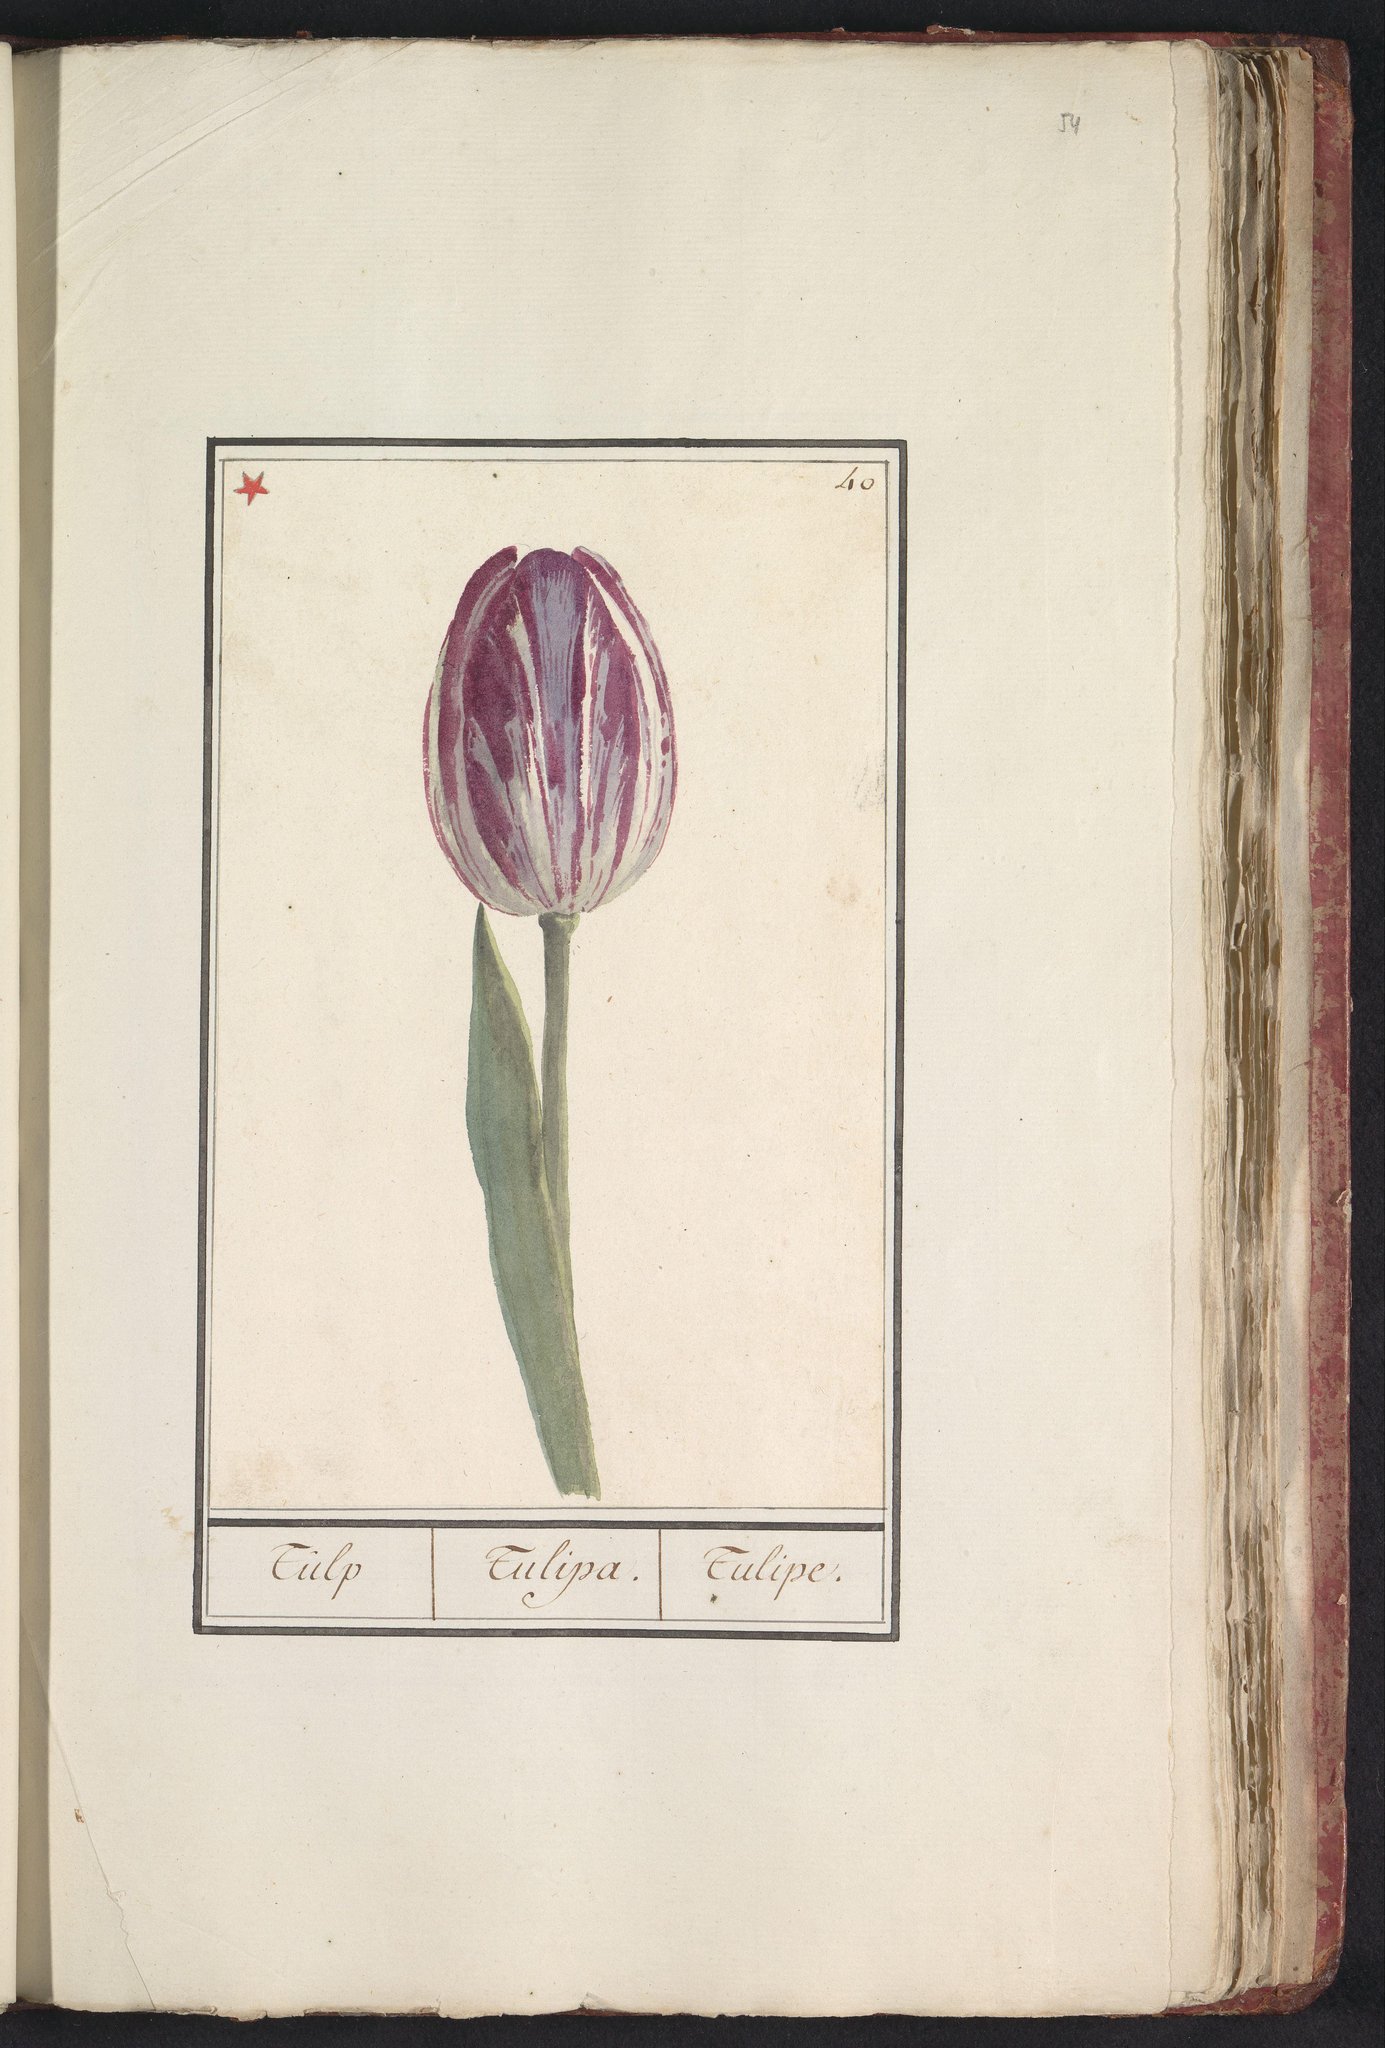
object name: drawing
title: Tulp (Tulipa)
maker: Anonymous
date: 1790-1814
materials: paint, paper, pencil, watercolor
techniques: brush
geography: southern netherlands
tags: flowers: tulip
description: Paars-witte tulp. Genummerd rechtsboven: 40. Linksboven gemerkt met een rood sterretje. Onderdeel van het eerste album met tekeningen van bloemen en planten. Achtste van twaalf albums met tekeningen van dieren, vogels en planten bekend rond 1600, gemaakt in opdracht van keizer Rudolf II. Met toelichting in Nederlands, Latijn en Frans.